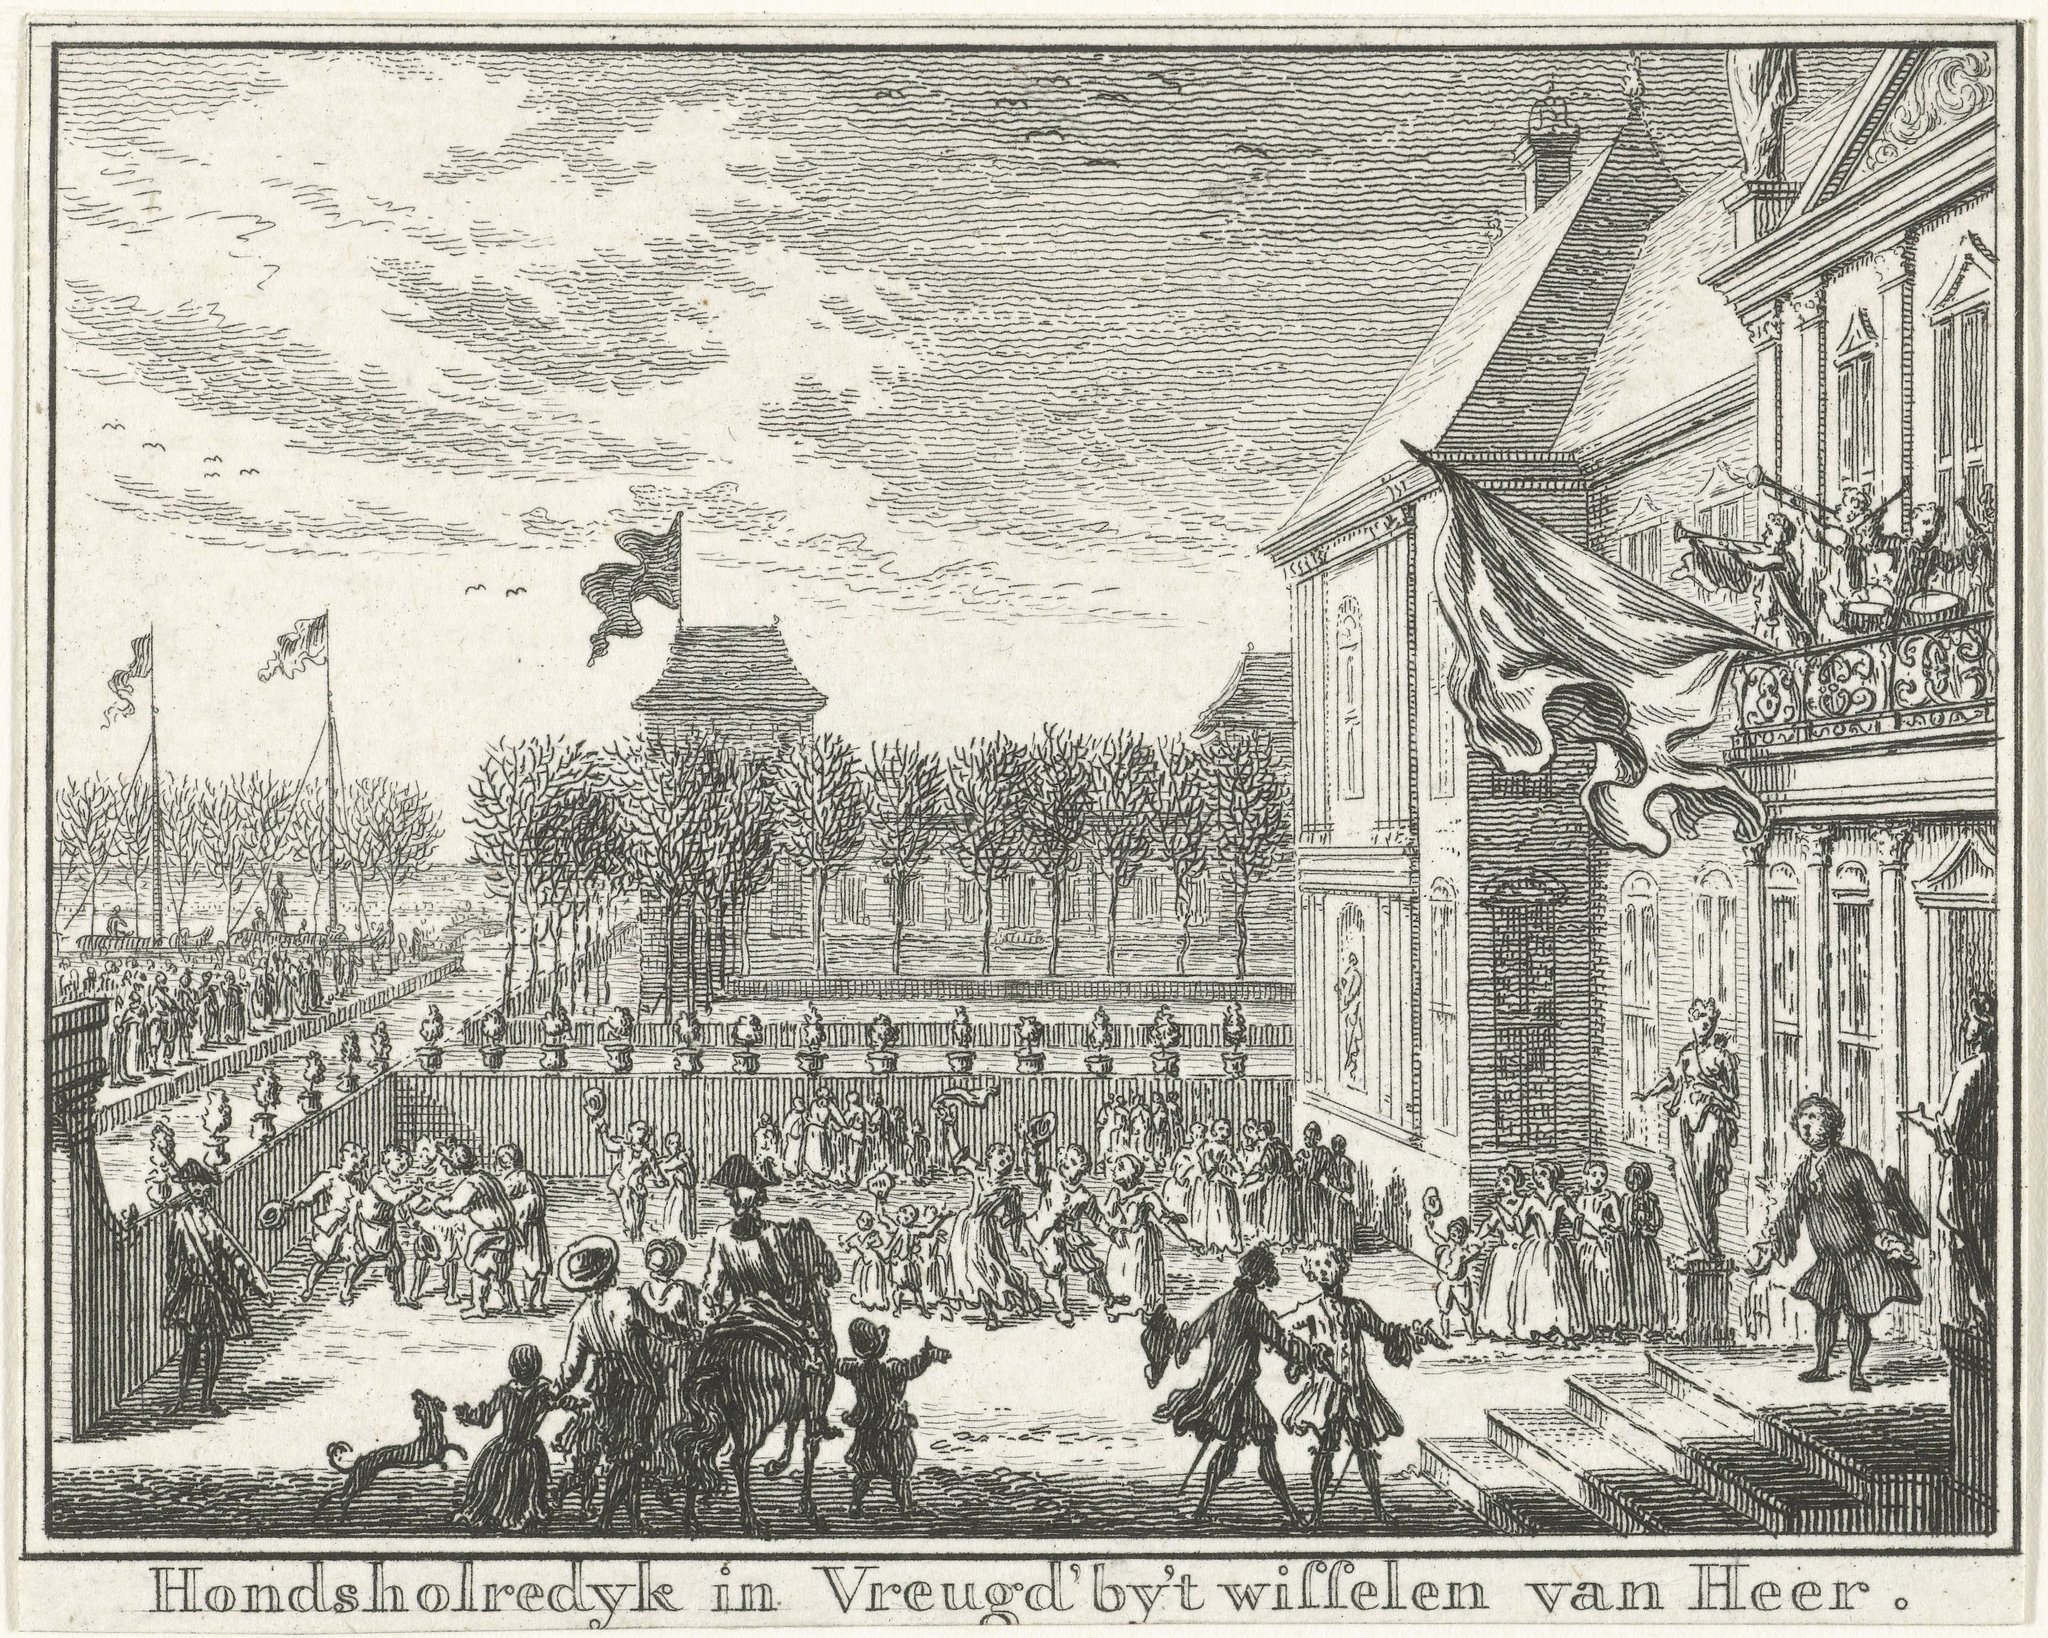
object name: print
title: Hondsholredyk in vreugd' by't wisselen van heer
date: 1754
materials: paper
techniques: engraving, etching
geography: amsterdam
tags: the hague, william v (prince of orange), carolina (prinses van oranje-nassau), anna van hannover, palace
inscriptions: collector's mark: Lugt 2228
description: Gezicht op de buitenkant van Paleis Honselaarsdijk met een vrolijke menigte tijdens de wisseling van eigenaar, 1754. Het paleis werd als onderdeel van de Pruisische heerlijkheden in Holland door Frederik de Grote verkocht aan Anna van Hannover op 21 februari 1754. Anna van Hannover kocht de Pruisische heerlijkheden in Holland als geheel voor f. 700.000 ten behoeve van haar destijds vijfjarige zoon erfstadhouder Willem V. Paleis Honselaarsdijk stelde ze ter beschikking aan haar dochter prinses Carolina.